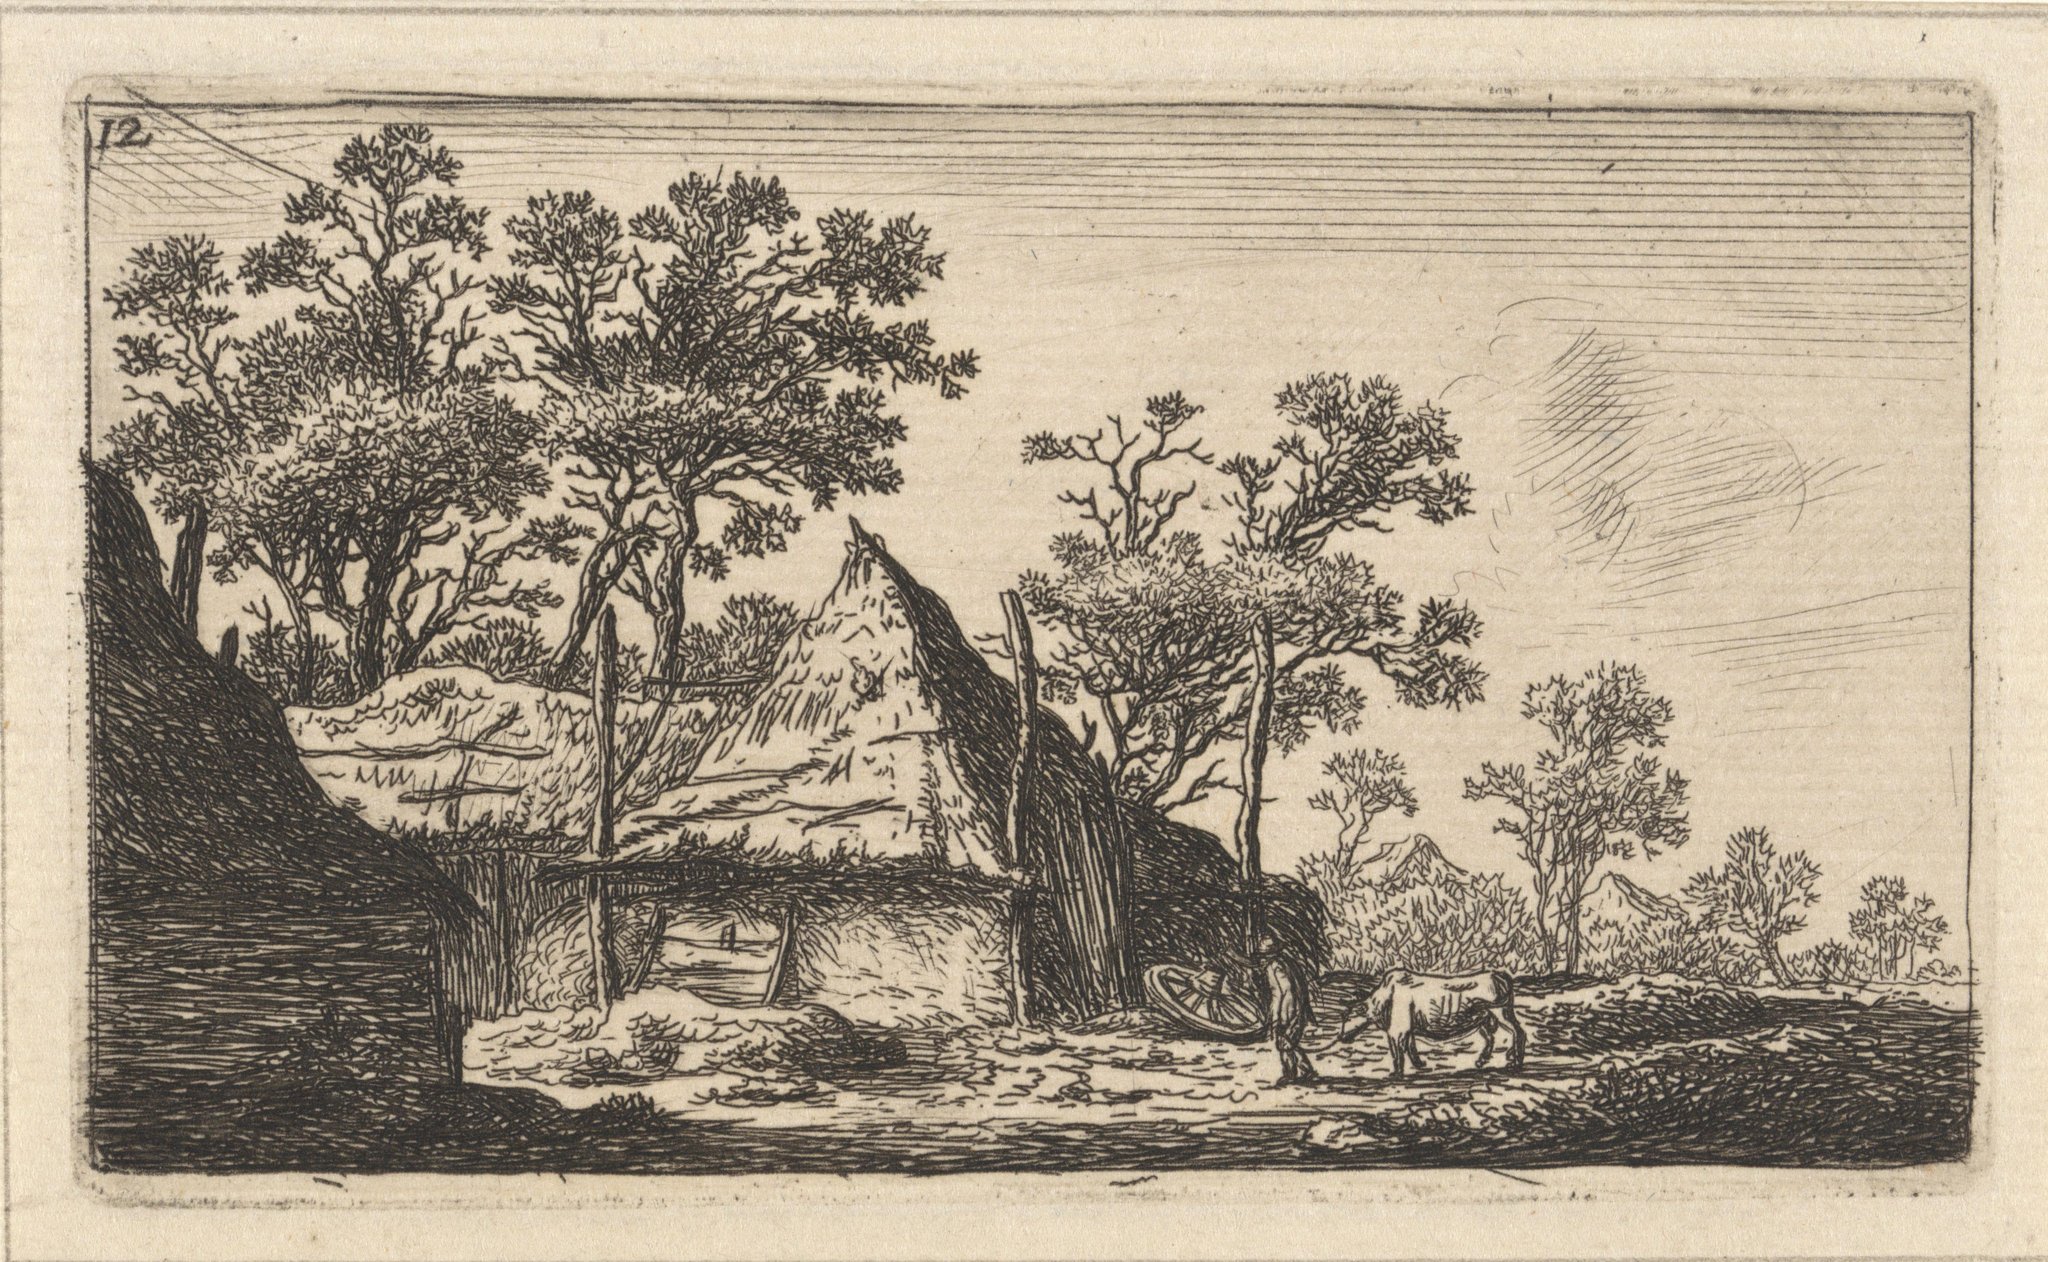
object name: print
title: Landschap met hooiberg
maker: hendrik schwegman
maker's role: draughtsman, print maker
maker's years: 1761-1816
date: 1786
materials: paper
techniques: engraving, etching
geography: haarlem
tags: hay-stack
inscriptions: collector's mark: Lugt 2228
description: Landschap met een hooiberg en bomen. Een man loopt met een koe aan een touw.